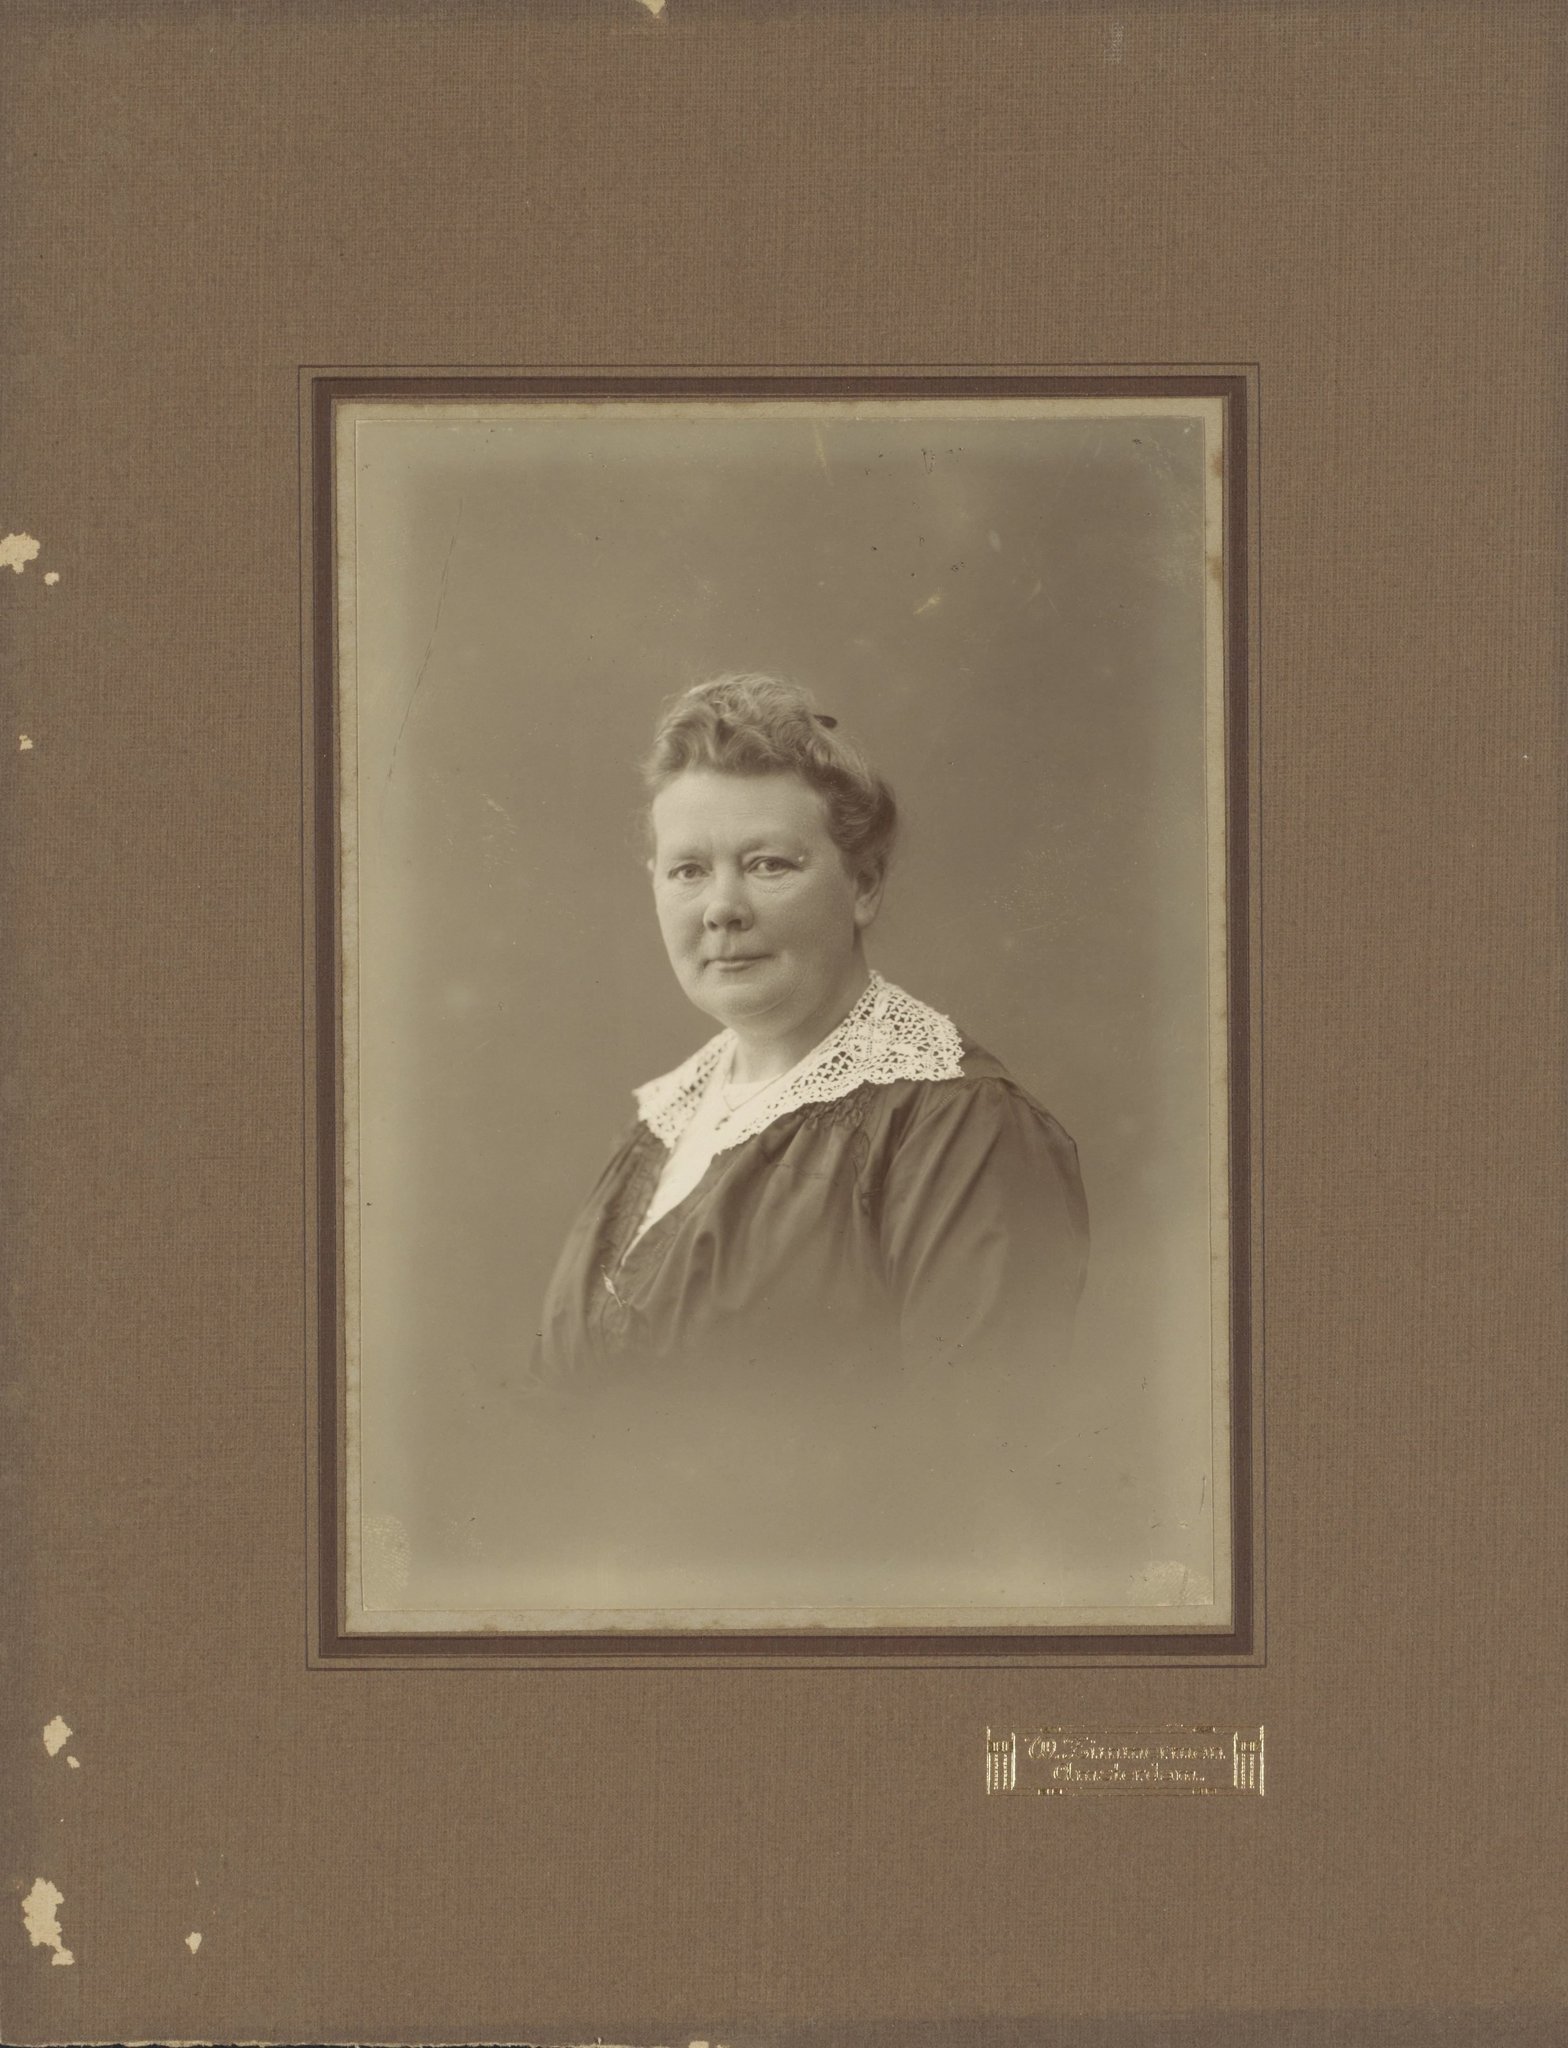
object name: photograph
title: Portret van een man met een kanten kraag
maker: guillame maximilien zimmermann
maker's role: fotograaf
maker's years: 1873-1951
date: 1916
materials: cardboard, paper, photographic support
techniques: daylight paper print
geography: amsterdam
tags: adult woman, neck-gear: collar, amsterdam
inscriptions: date: ‘1916’, name: ‘W. Zimmerman Amsterdam’